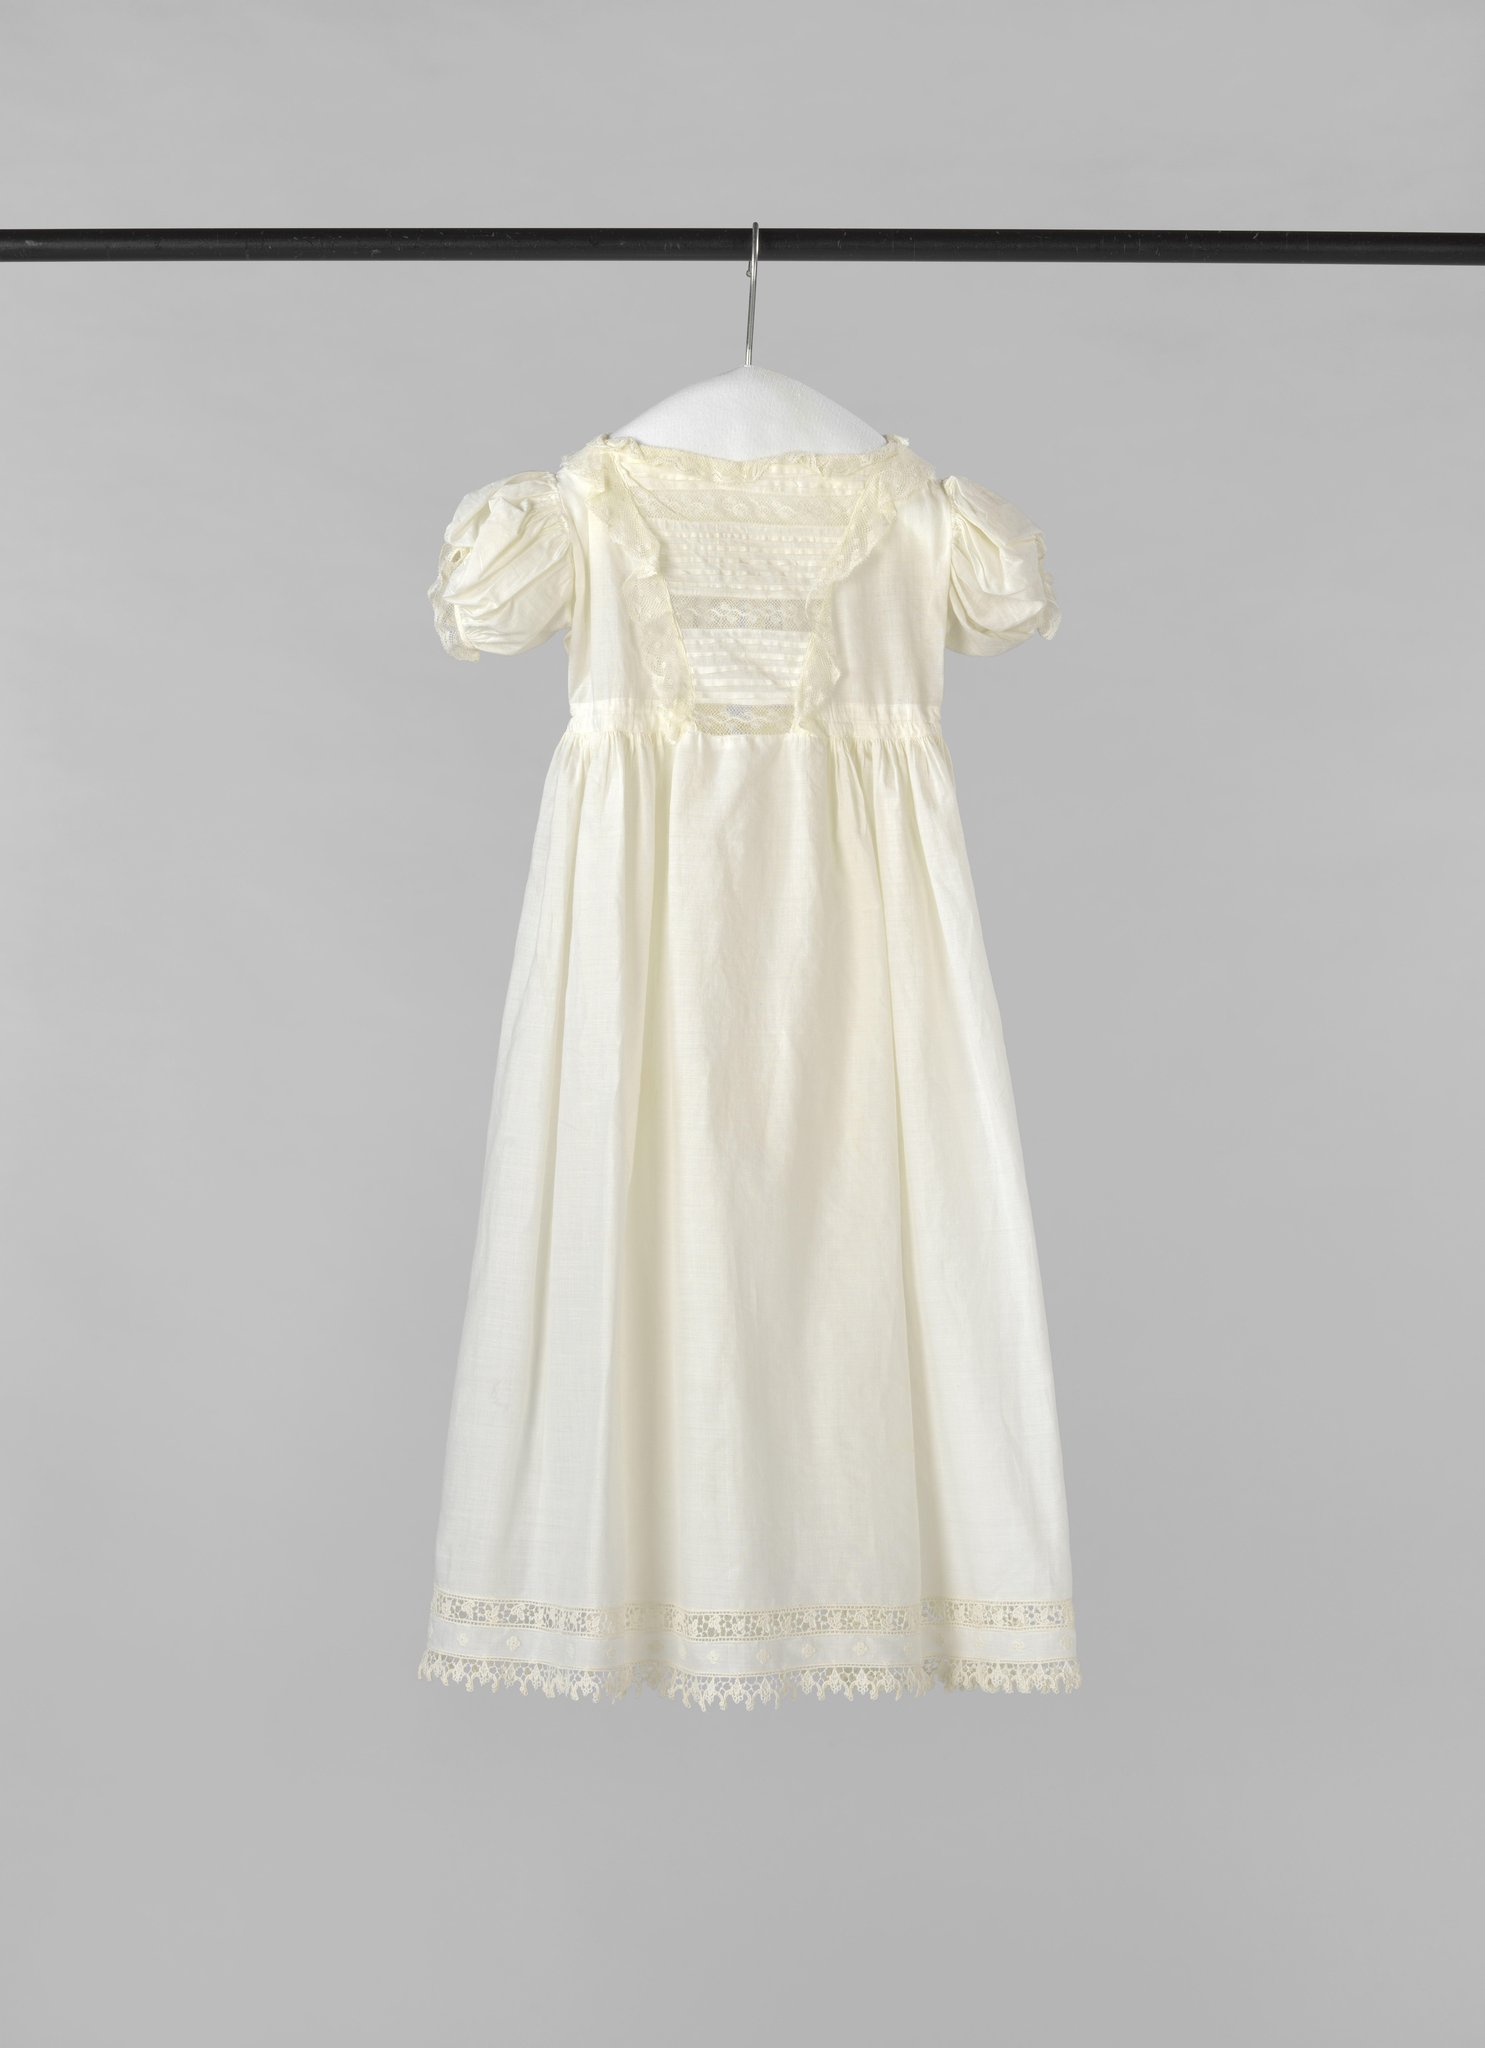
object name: childrenswear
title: Kleuterjurk van batisten randstof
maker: Anonymous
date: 1907-1909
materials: textile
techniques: lace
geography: amsterdam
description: Kleuterjurkje van batisten randstof, versierd met valenciennetjes. Belle Époque. Model: Lijfje van voren glad met taillepasje, maar vanachter in te rimpelen. Driehoekig inzetstukje van kant en batist met oprijgjes. Brede hals. Sluiting alleen met bordjes in hals en taille. Wijde pofmouwtjes die met een binnen bandje in vorm gehouden wordt. Onderaan een glad biesje. Ruim aangerimpelde eenbaanserokje van randstof. Versiering: Tussenzetsels en strookjes van Valenciennetjes, in en langs het driehoekige voorstukje, langs de hals en de mouwtjes. Randstof. Grof en opengewerkt, machinaal borduursel, dat een tussen ...en een schulpjesrand heeft. Daartussenin een glad stukje me losse rozetjes. Toestand: Gewassen 1979.